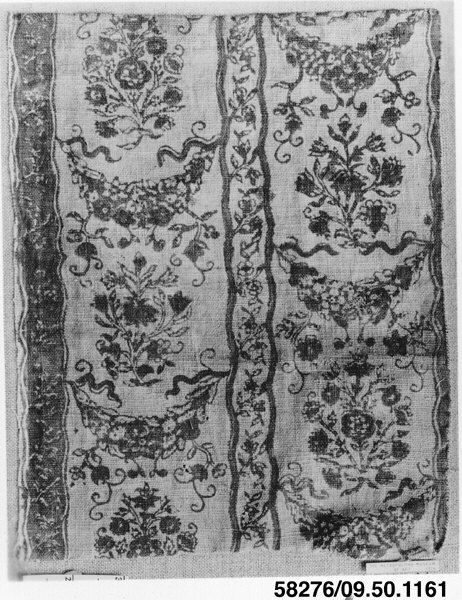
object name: fragment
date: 1767-1800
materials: cotton